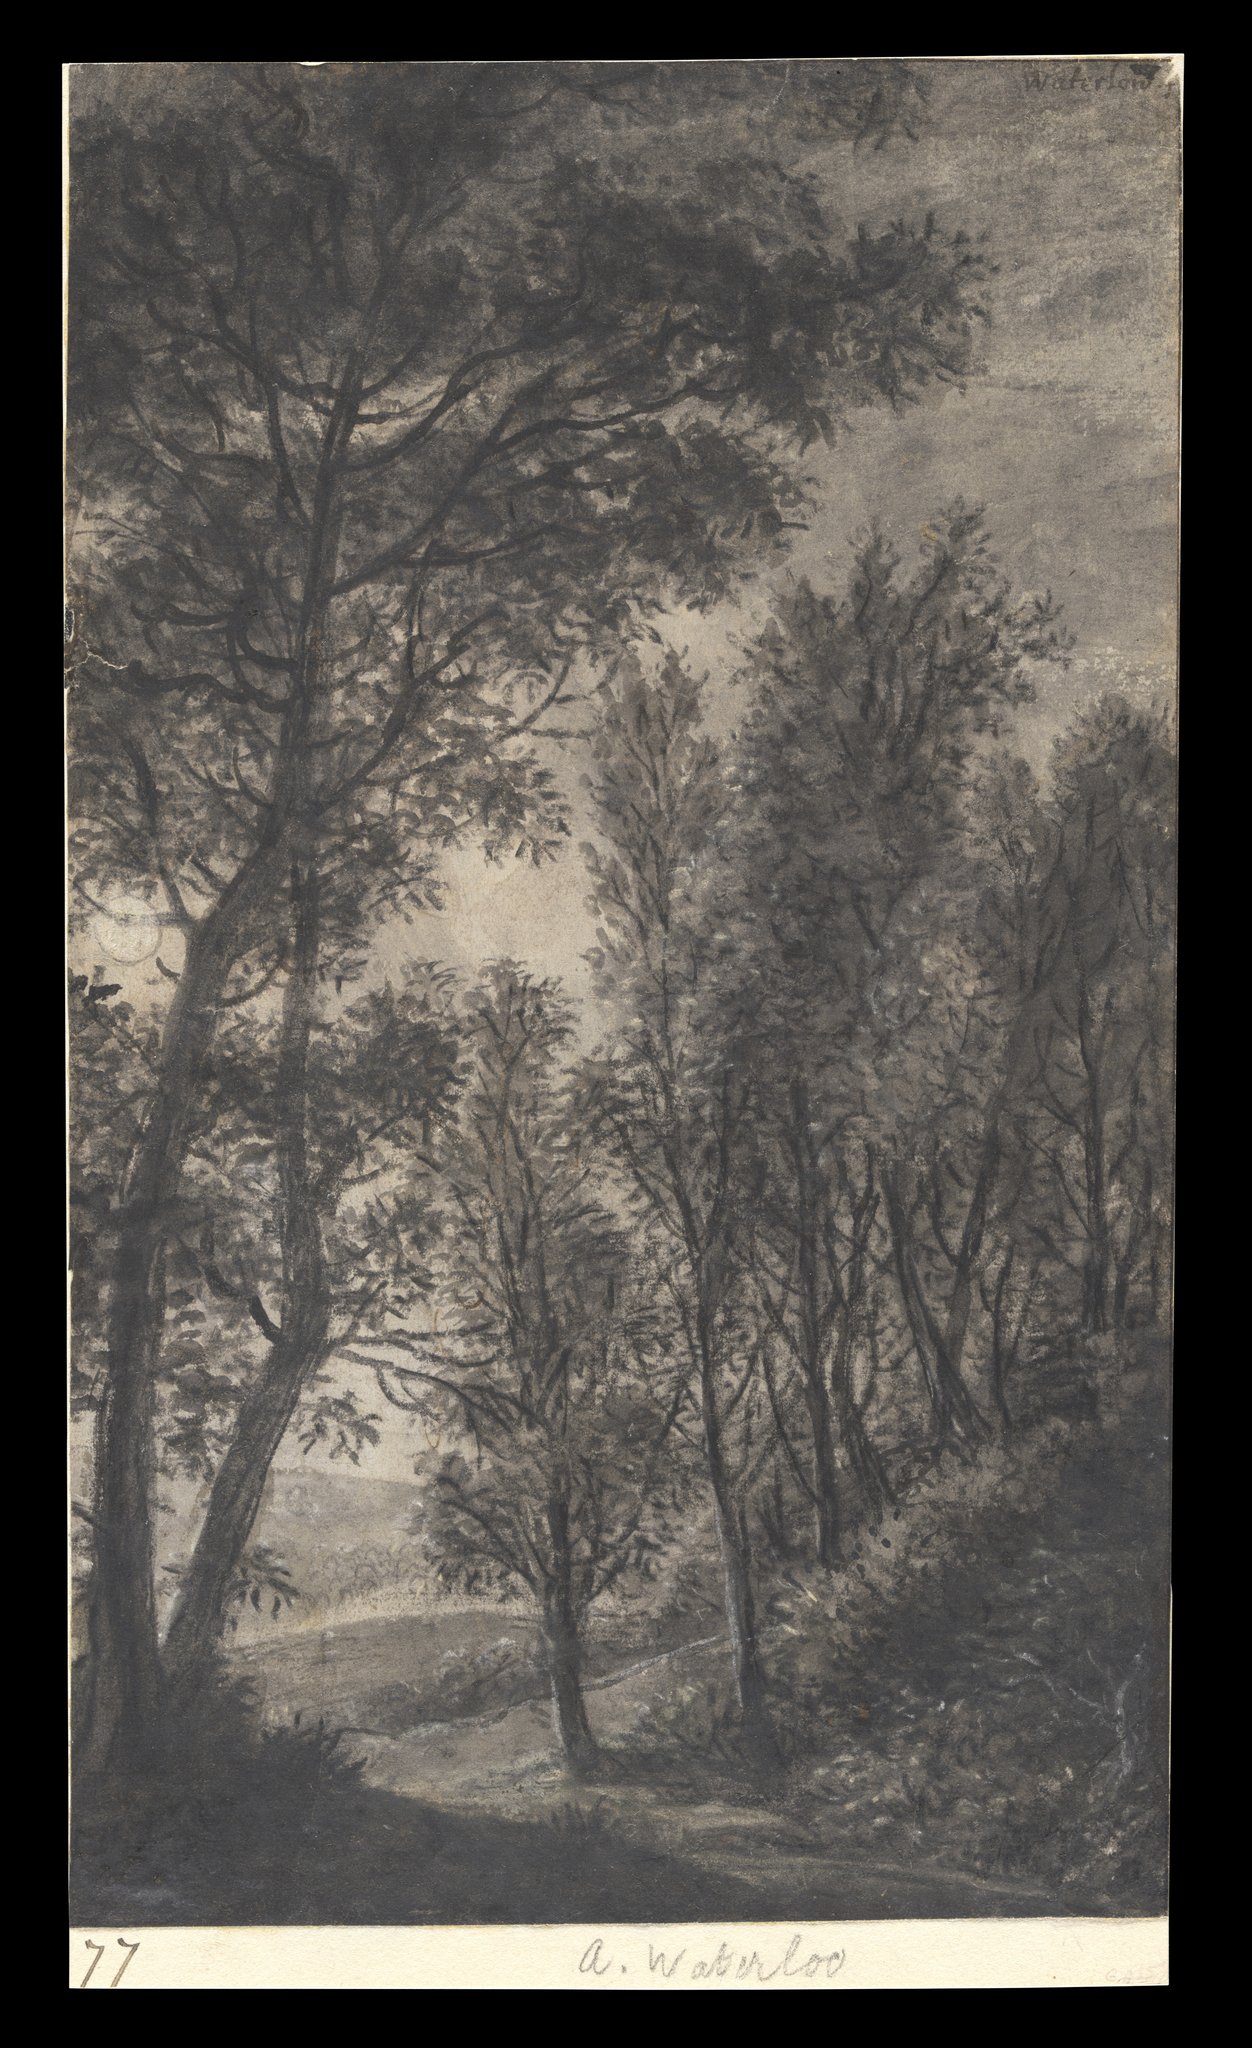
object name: drawing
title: Wooded Landscape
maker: anthonie waterloo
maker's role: artist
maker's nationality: dutch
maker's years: 1609-1690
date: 1630-1690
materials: chalk, ink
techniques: brush, heightening, pen, wash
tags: landscapes